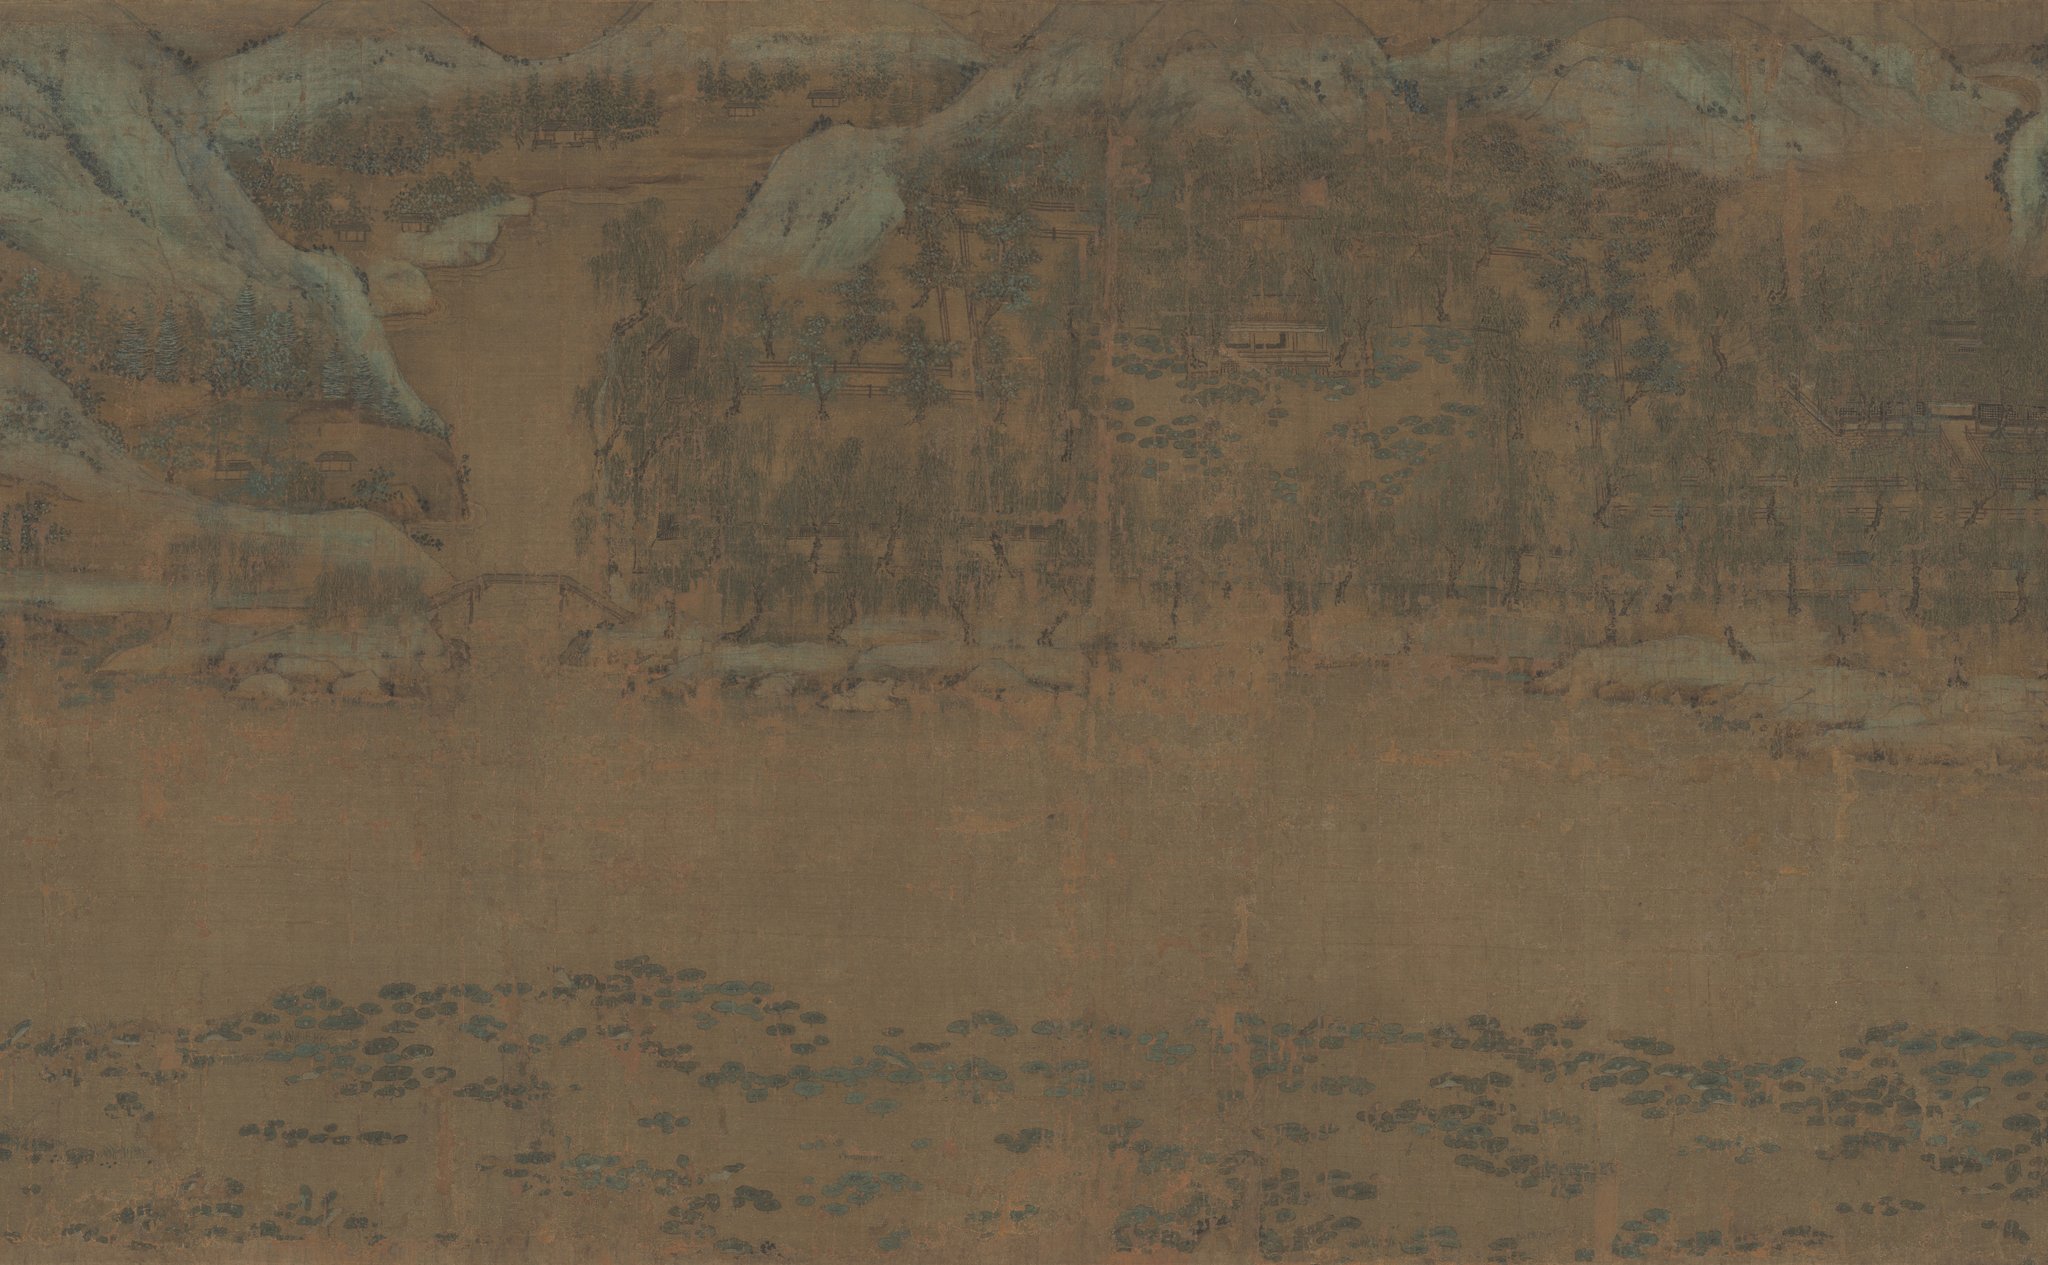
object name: handscroll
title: Fisherman's Lodge At Mount Xisai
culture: chinese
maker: li jie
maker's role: artist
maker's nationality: chinese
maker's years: 1124-1197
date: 1170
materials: ink, silk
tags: mountains,landscapes